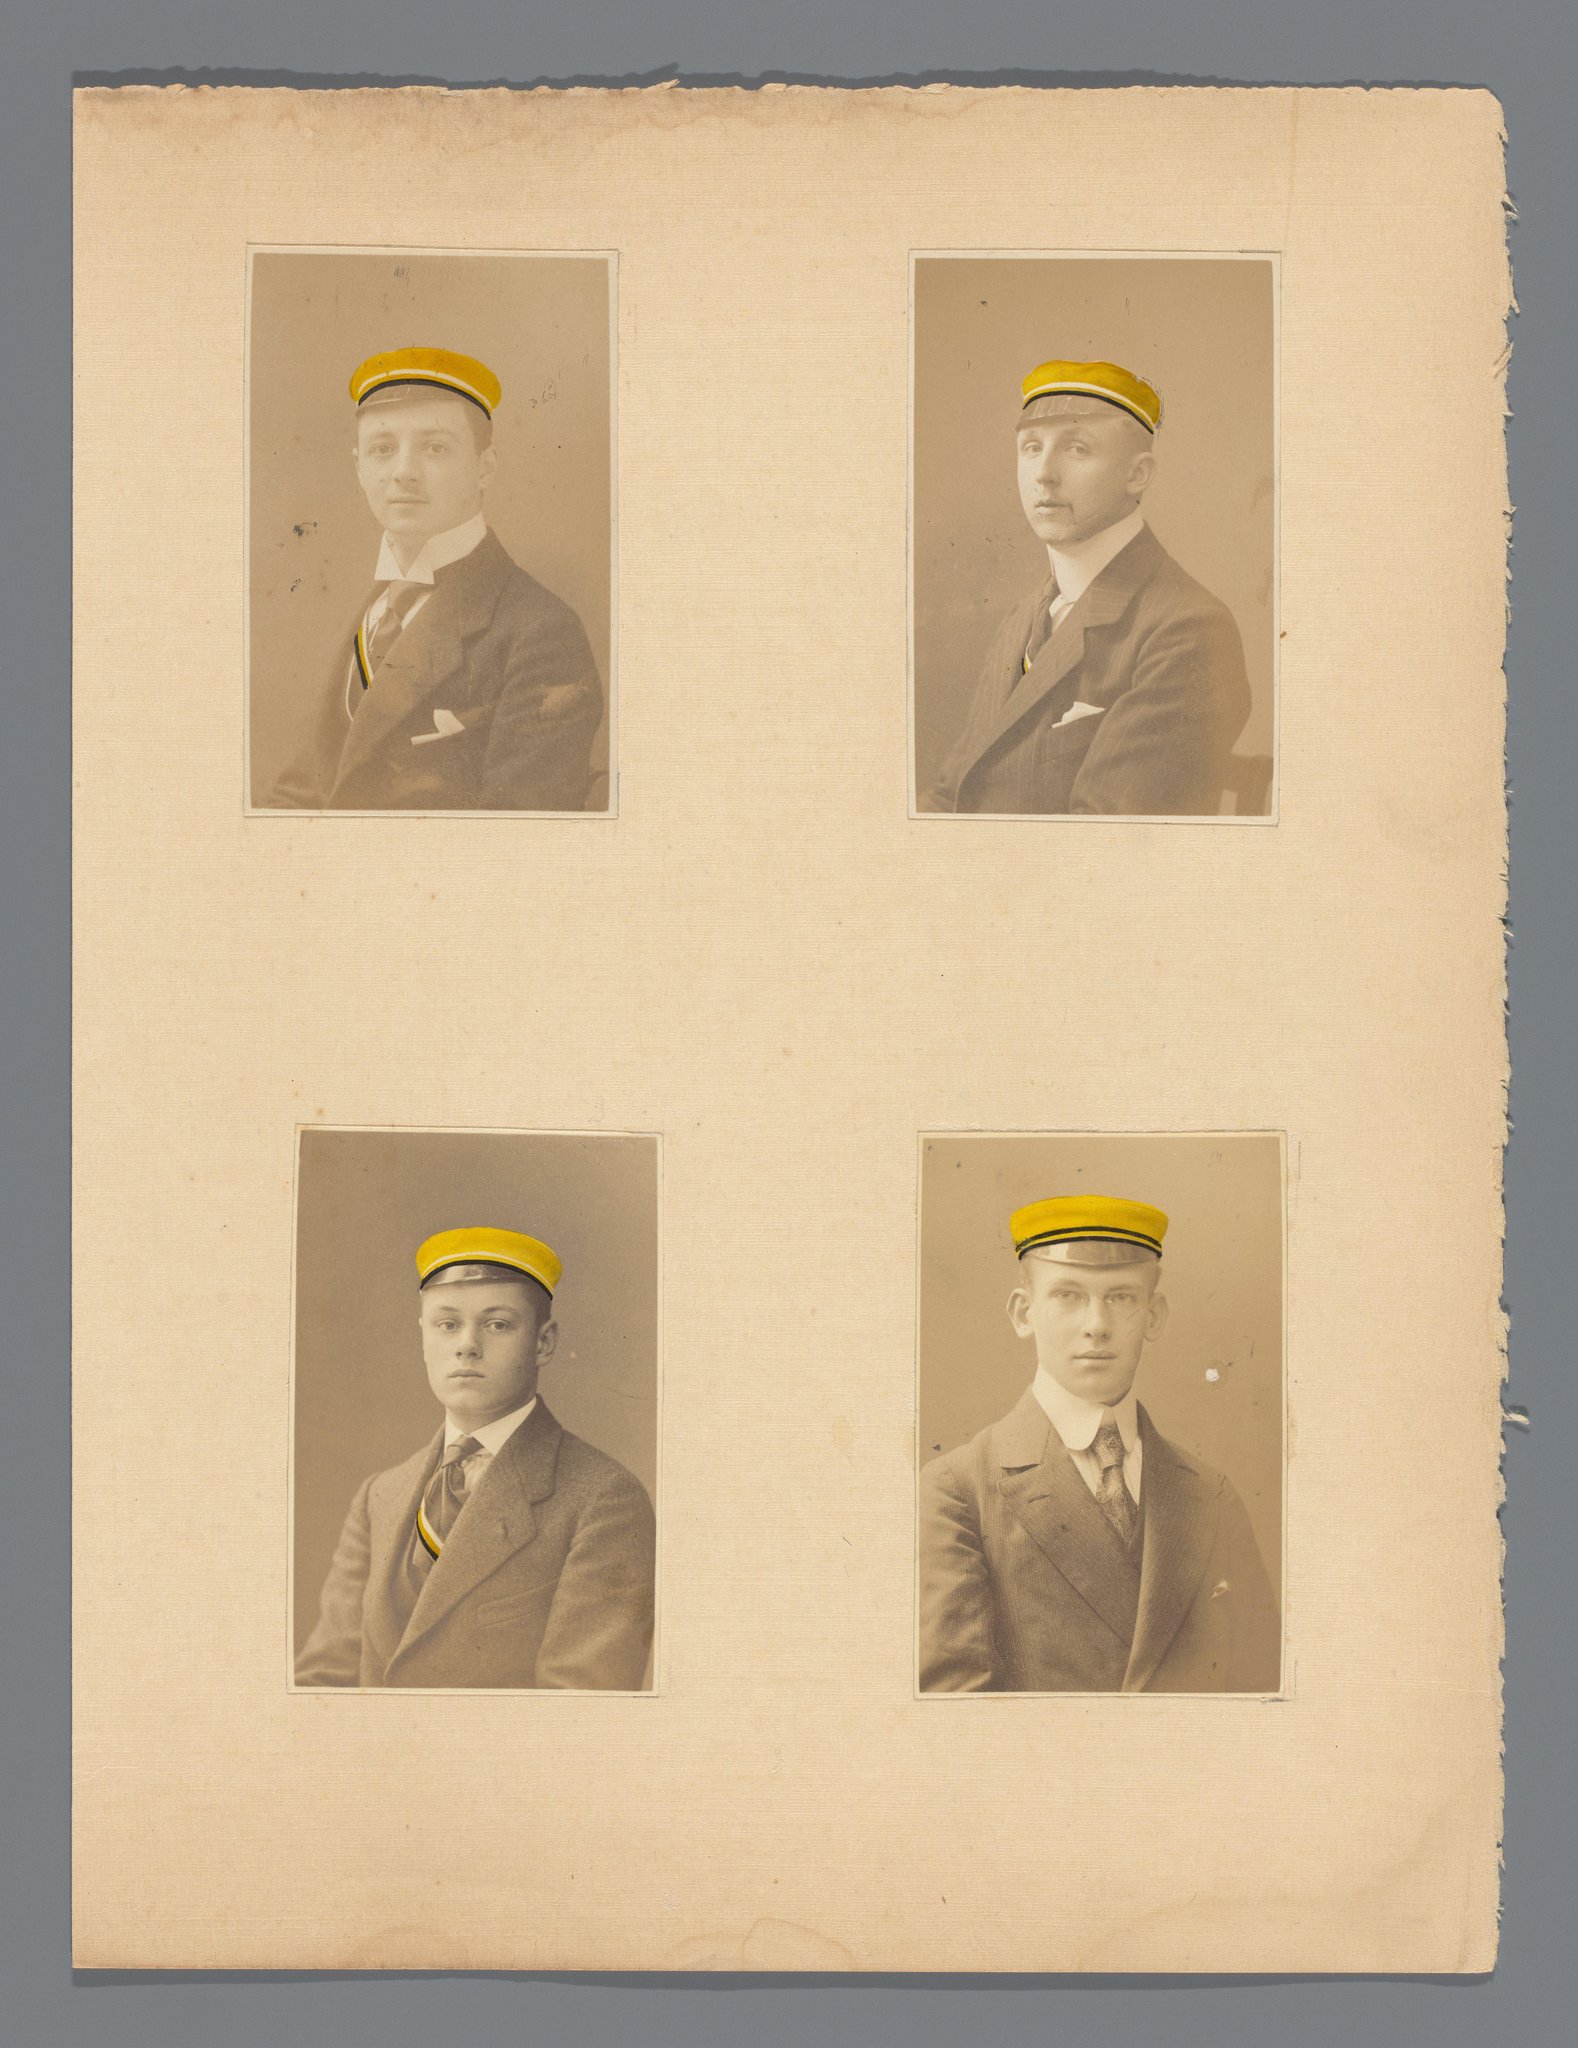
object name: photograph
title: Blad met vier portretten van studenten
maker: Anonymous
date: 1890-1920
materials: cardboard, paint, photographic support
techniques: gelatin silver print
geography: germany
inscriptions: inscription: ‘Etudiants Heidelberg’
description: De petten en sjerpen zijn gekleurd met gele verf.